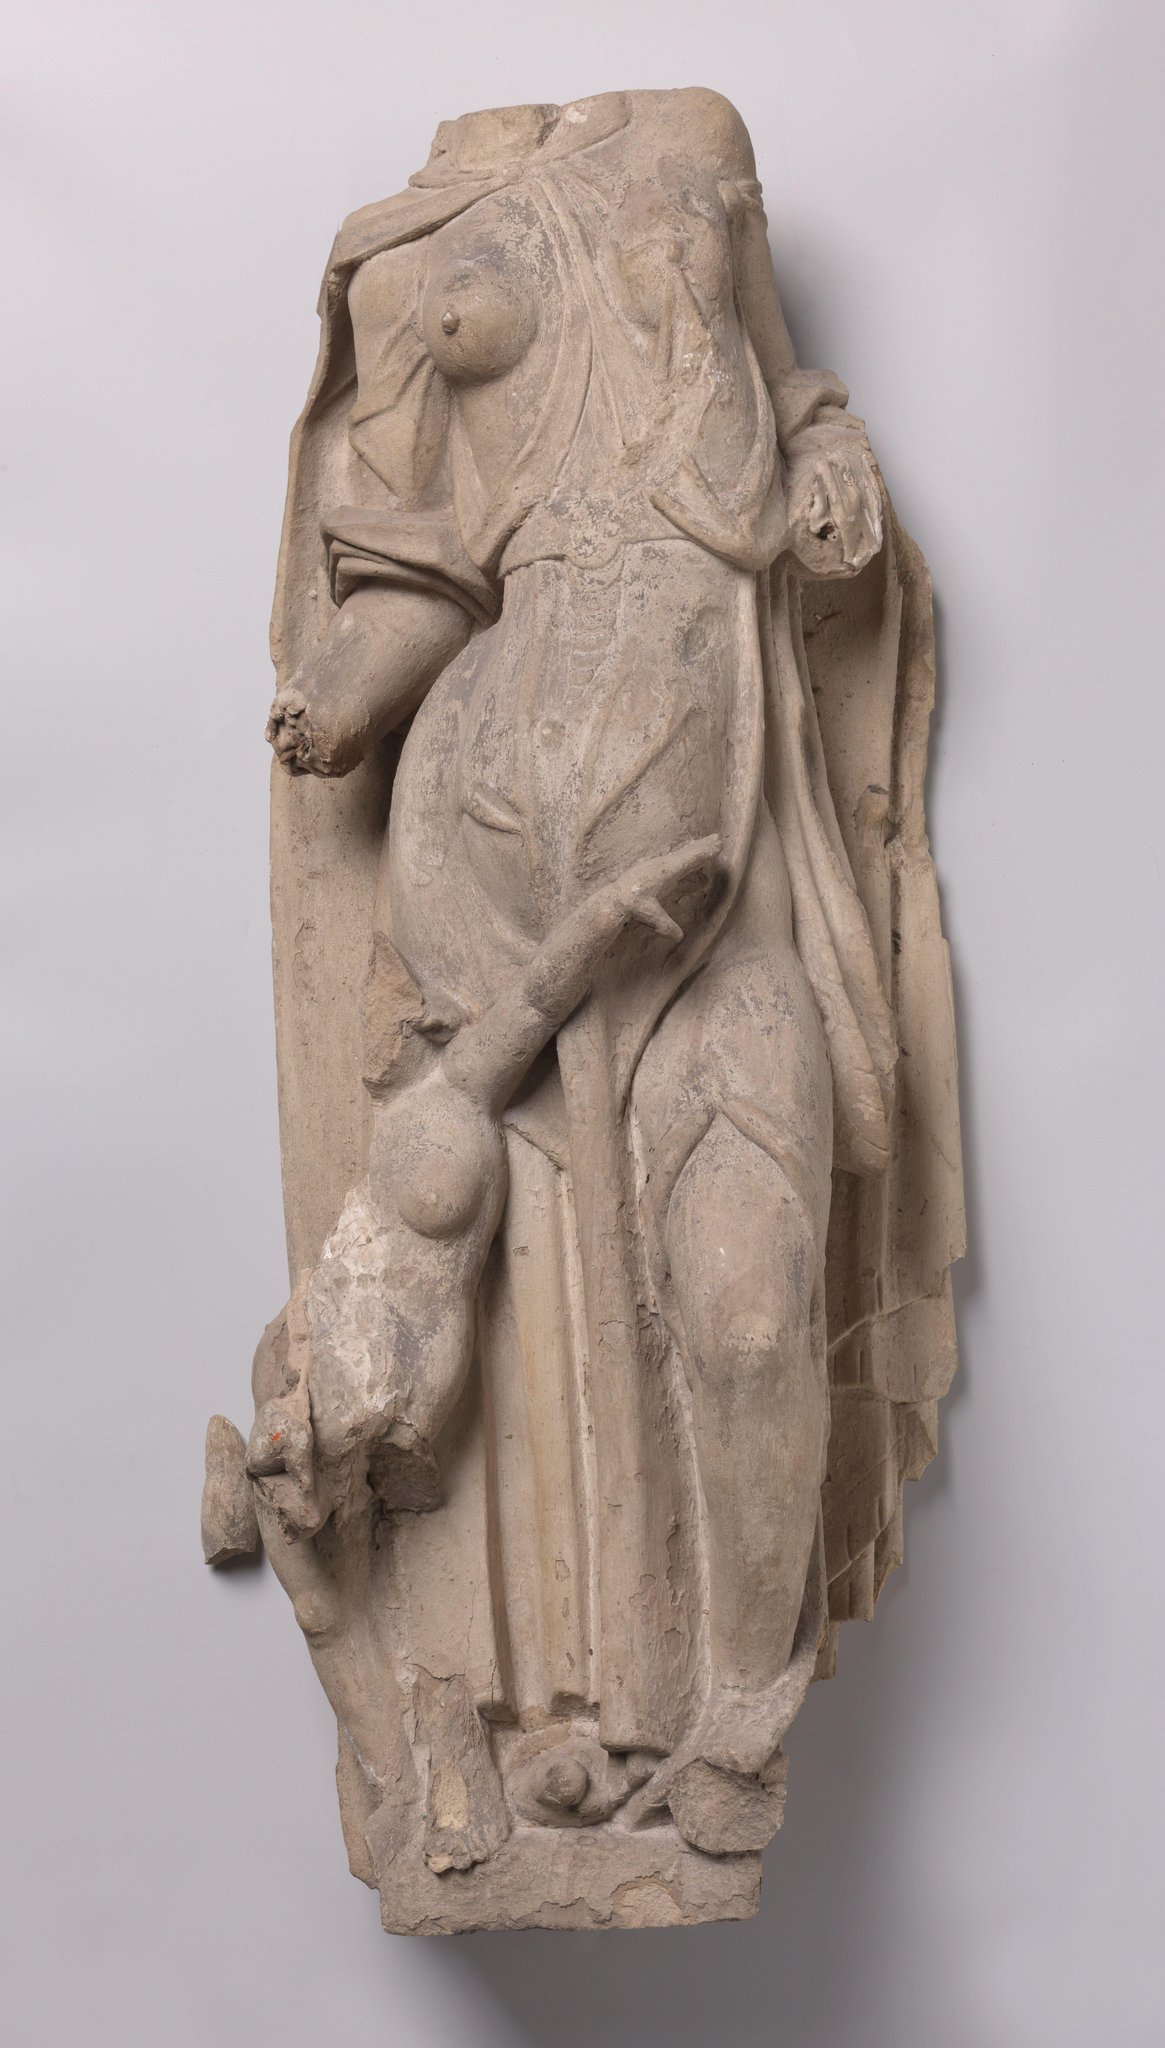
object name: sculpture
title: Charity, from the Facade of the Penninckshuis in Deventer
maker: Anonymous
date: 1588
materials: stone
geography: westphalia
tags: penninckhuis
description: Vrouw (Charitas) ten voeten uit staande, met haar linkerbeen gebogen. Links van haar staat een naakt kind. De vrouw draagt een gewaad dat rechter borst en linker been bloot laat. Om haar middel draagt zij een riem, waaraan een geschubde versiering. Van het beeld ontbreken enkele delen. Het beeld hoort bij zes beelden (BK-18757-A t/m BK-18757-F).